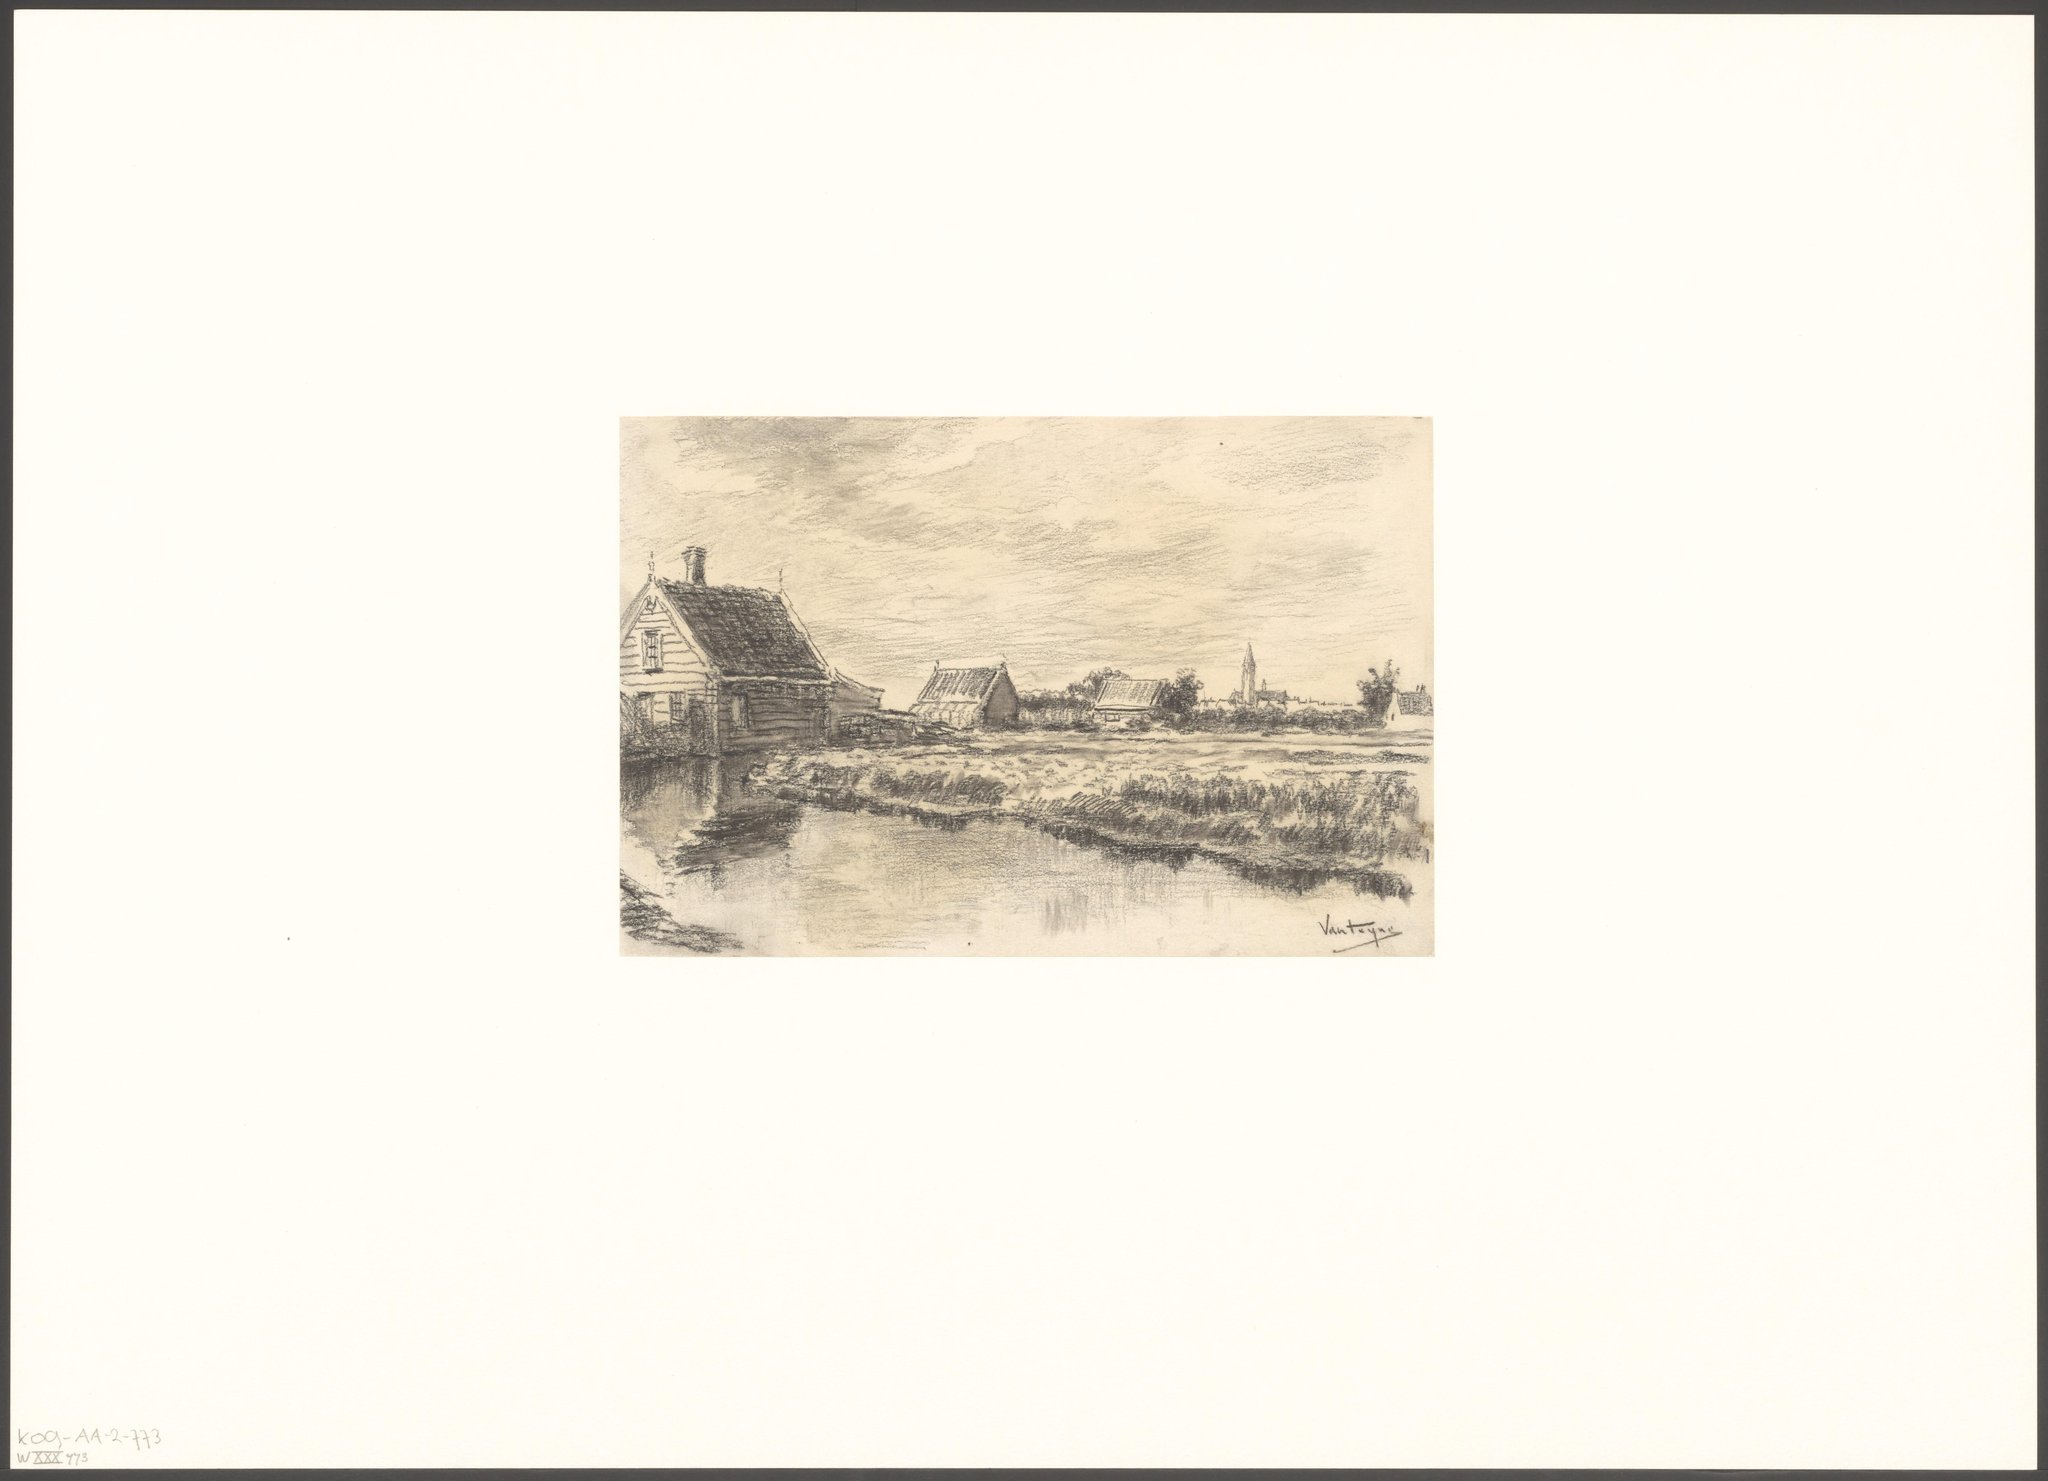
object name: drawing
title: Gezicht op groentetuinen gezien vanuit de Marco Polostraat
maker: anthonie van teijn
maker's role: draughtsman, painter, print maker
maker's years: 1863-1943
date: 1910-1927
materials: chalk, paper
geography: amsterdam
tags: horticulture, vegetable culture, market gardening, city-view in general; 'veduta', parts of church exterior and annexes: spire, small canal, ditch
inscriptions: signature: ‘VanTeyne’, inscription: ‘Groenten tuinen gezien (...) Oct 1927. / vEck’, collector's mark: Lugt 800a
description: Tekening binnen de Atlas Van Eck ingedeeld op wijknummer 30.